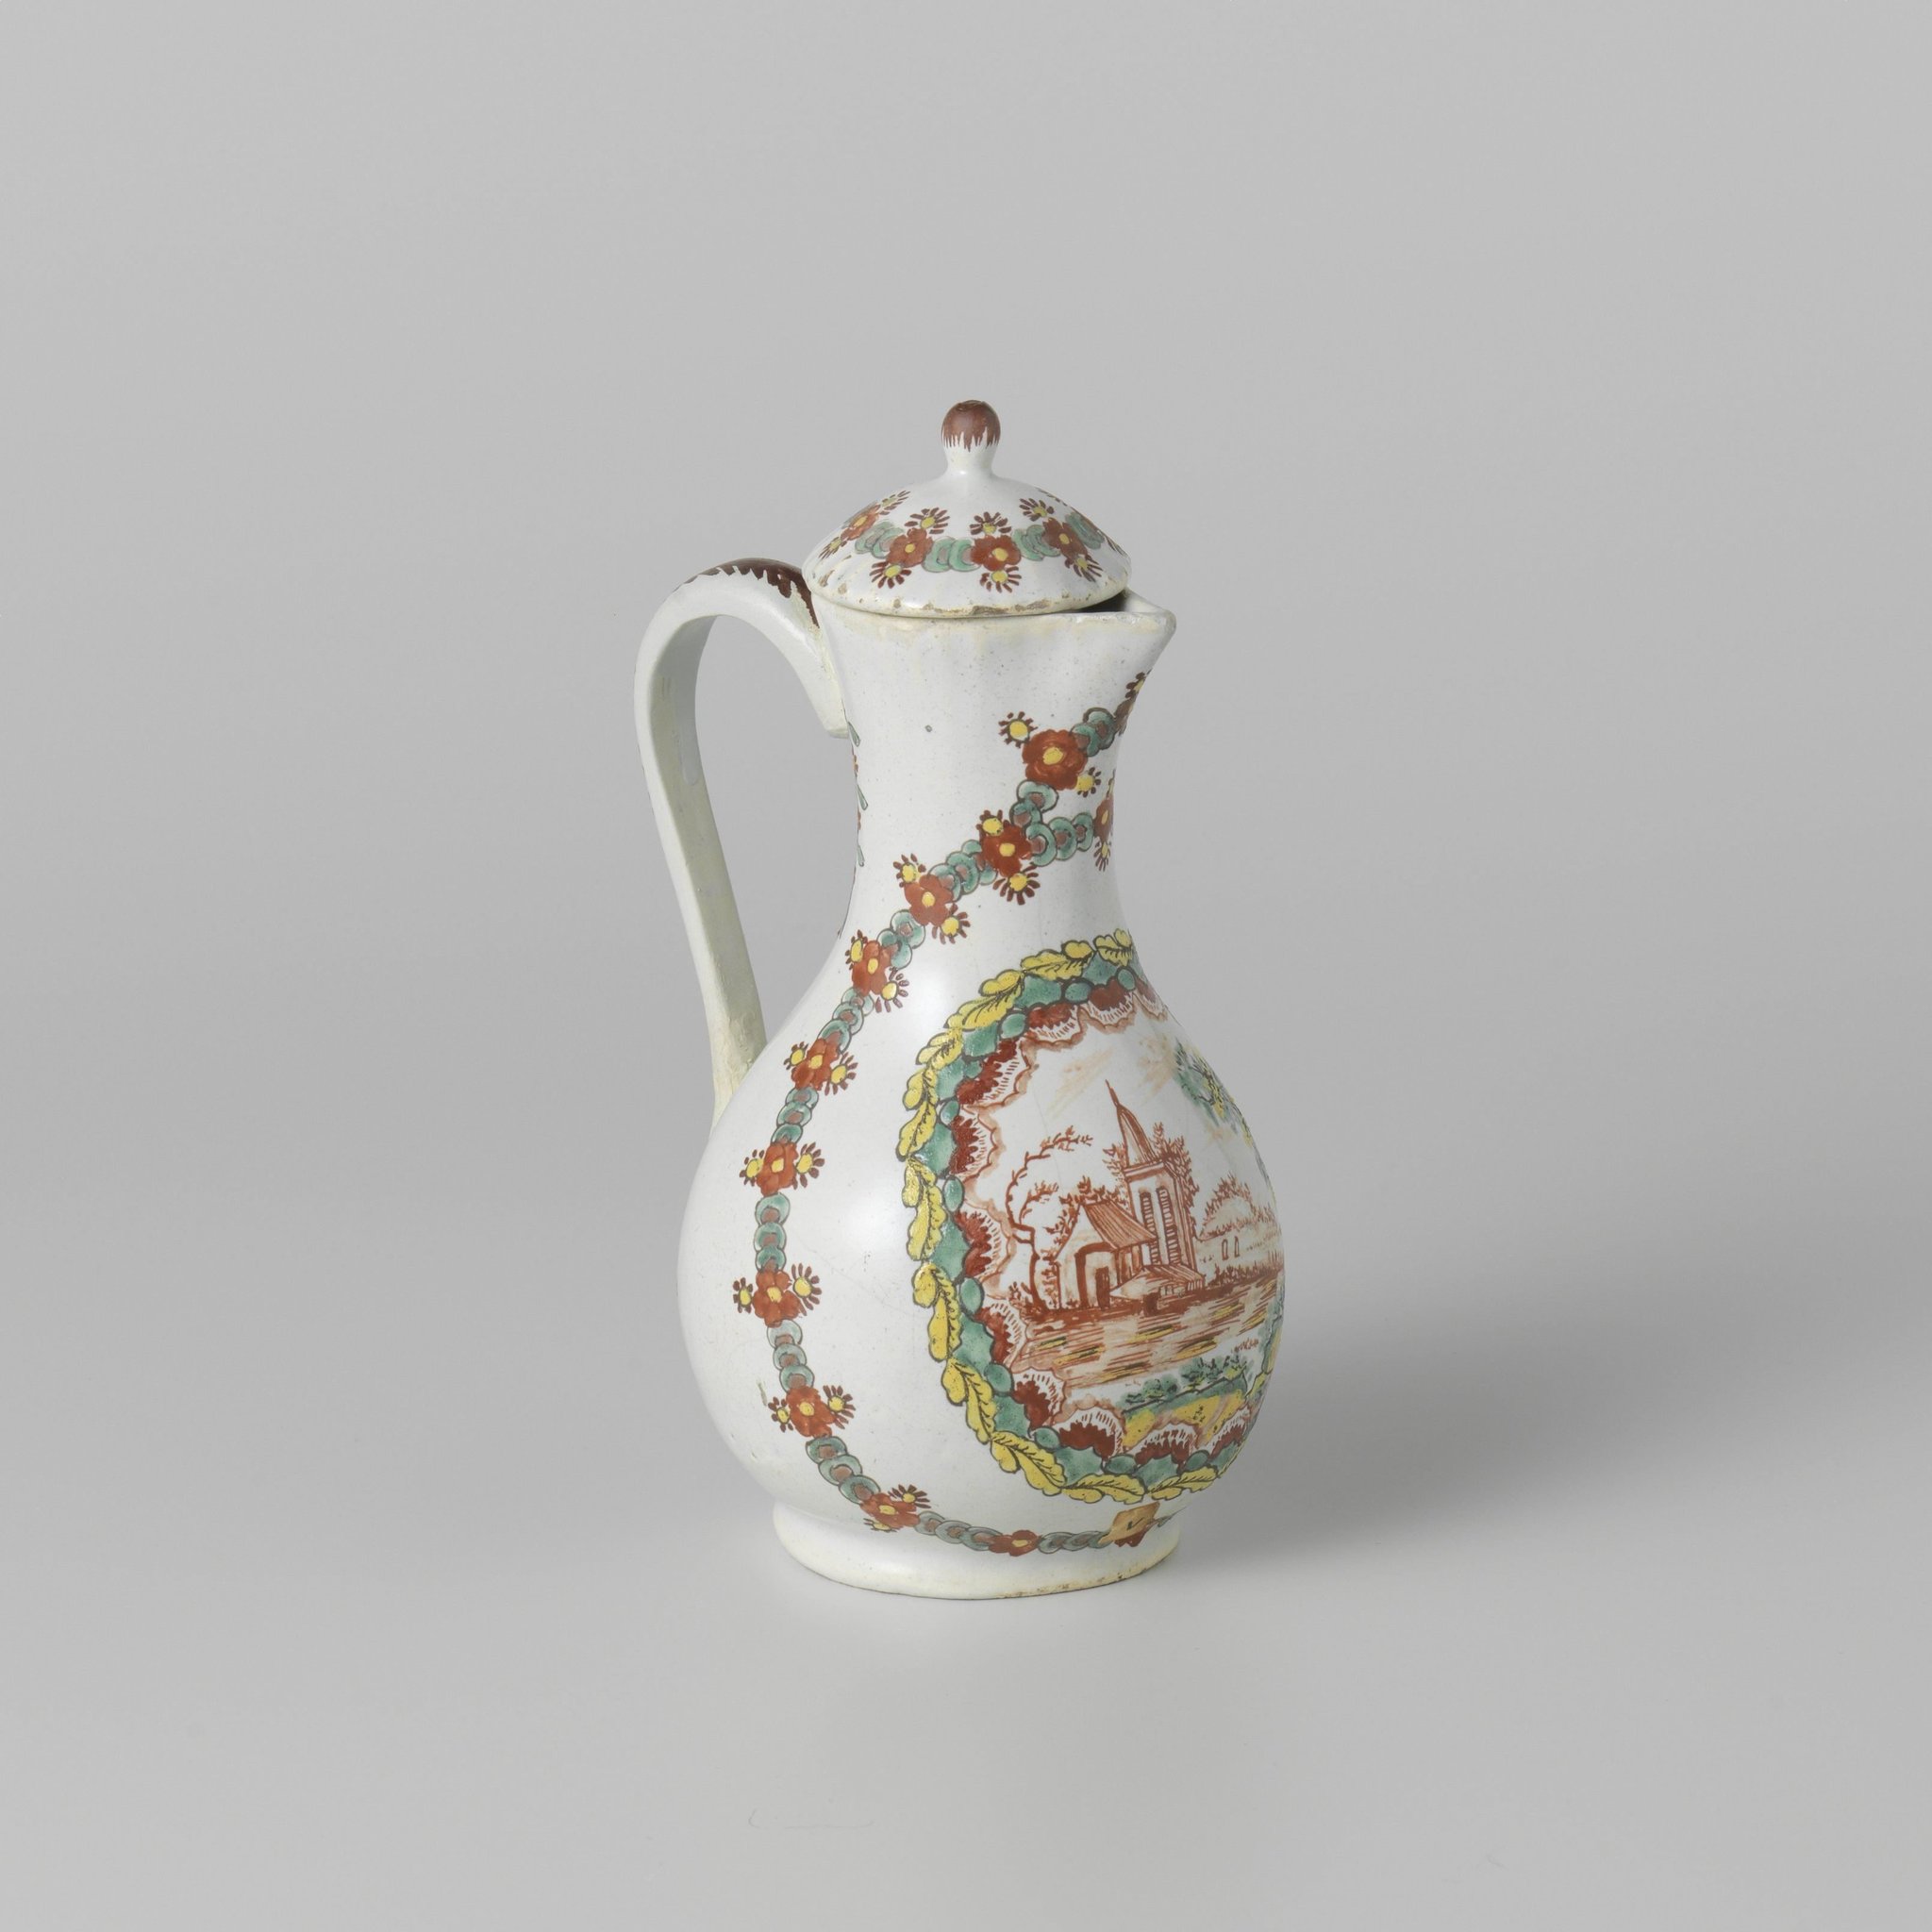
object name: milk jug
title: Melkkan van veelkleurig beschilderde faïence met decor van een landschap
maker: Anonymous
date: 1760-1790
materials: faience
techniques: kiln, painted, polychromy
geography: delft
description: Melkkan van veelkleurig beschilderde faïence met een decor van een landschap binnen een krans.